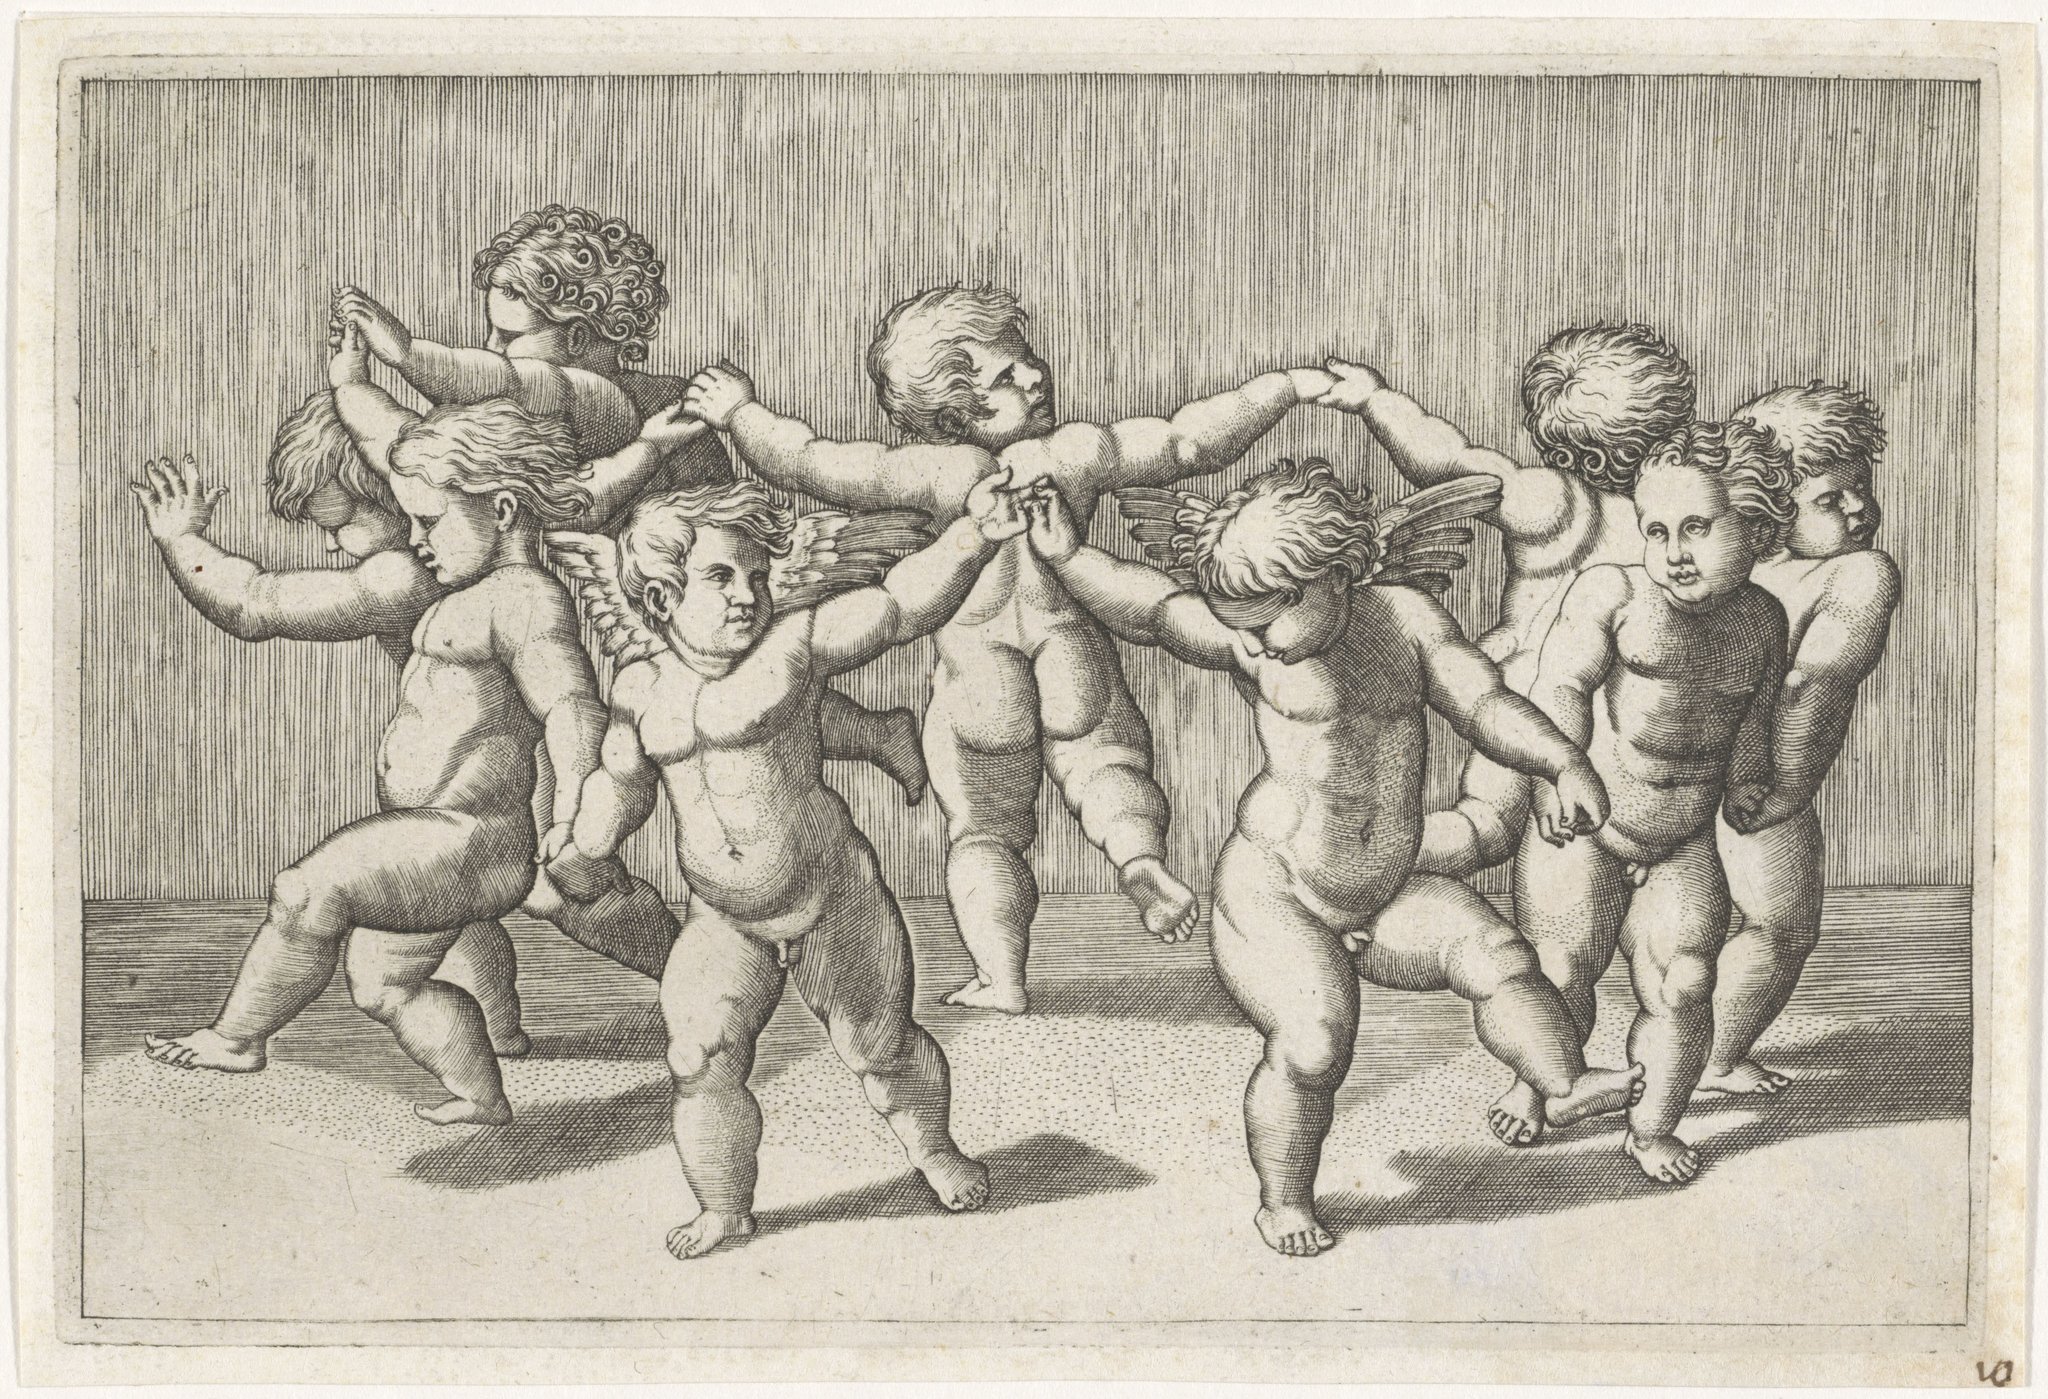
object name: print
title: Dansende putti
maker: Anonymous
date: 1517-1575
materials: paper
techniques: engraving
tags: dancing, cupids: 'amores', 'amoretti', 'putti'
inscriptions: number: ‘10’, collector's mark: Lugt 10, collector's mark: Lugt 11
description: Kopie naar prent van Marcantonio Raimondi met toevoeging van gearceerde achtergrond.